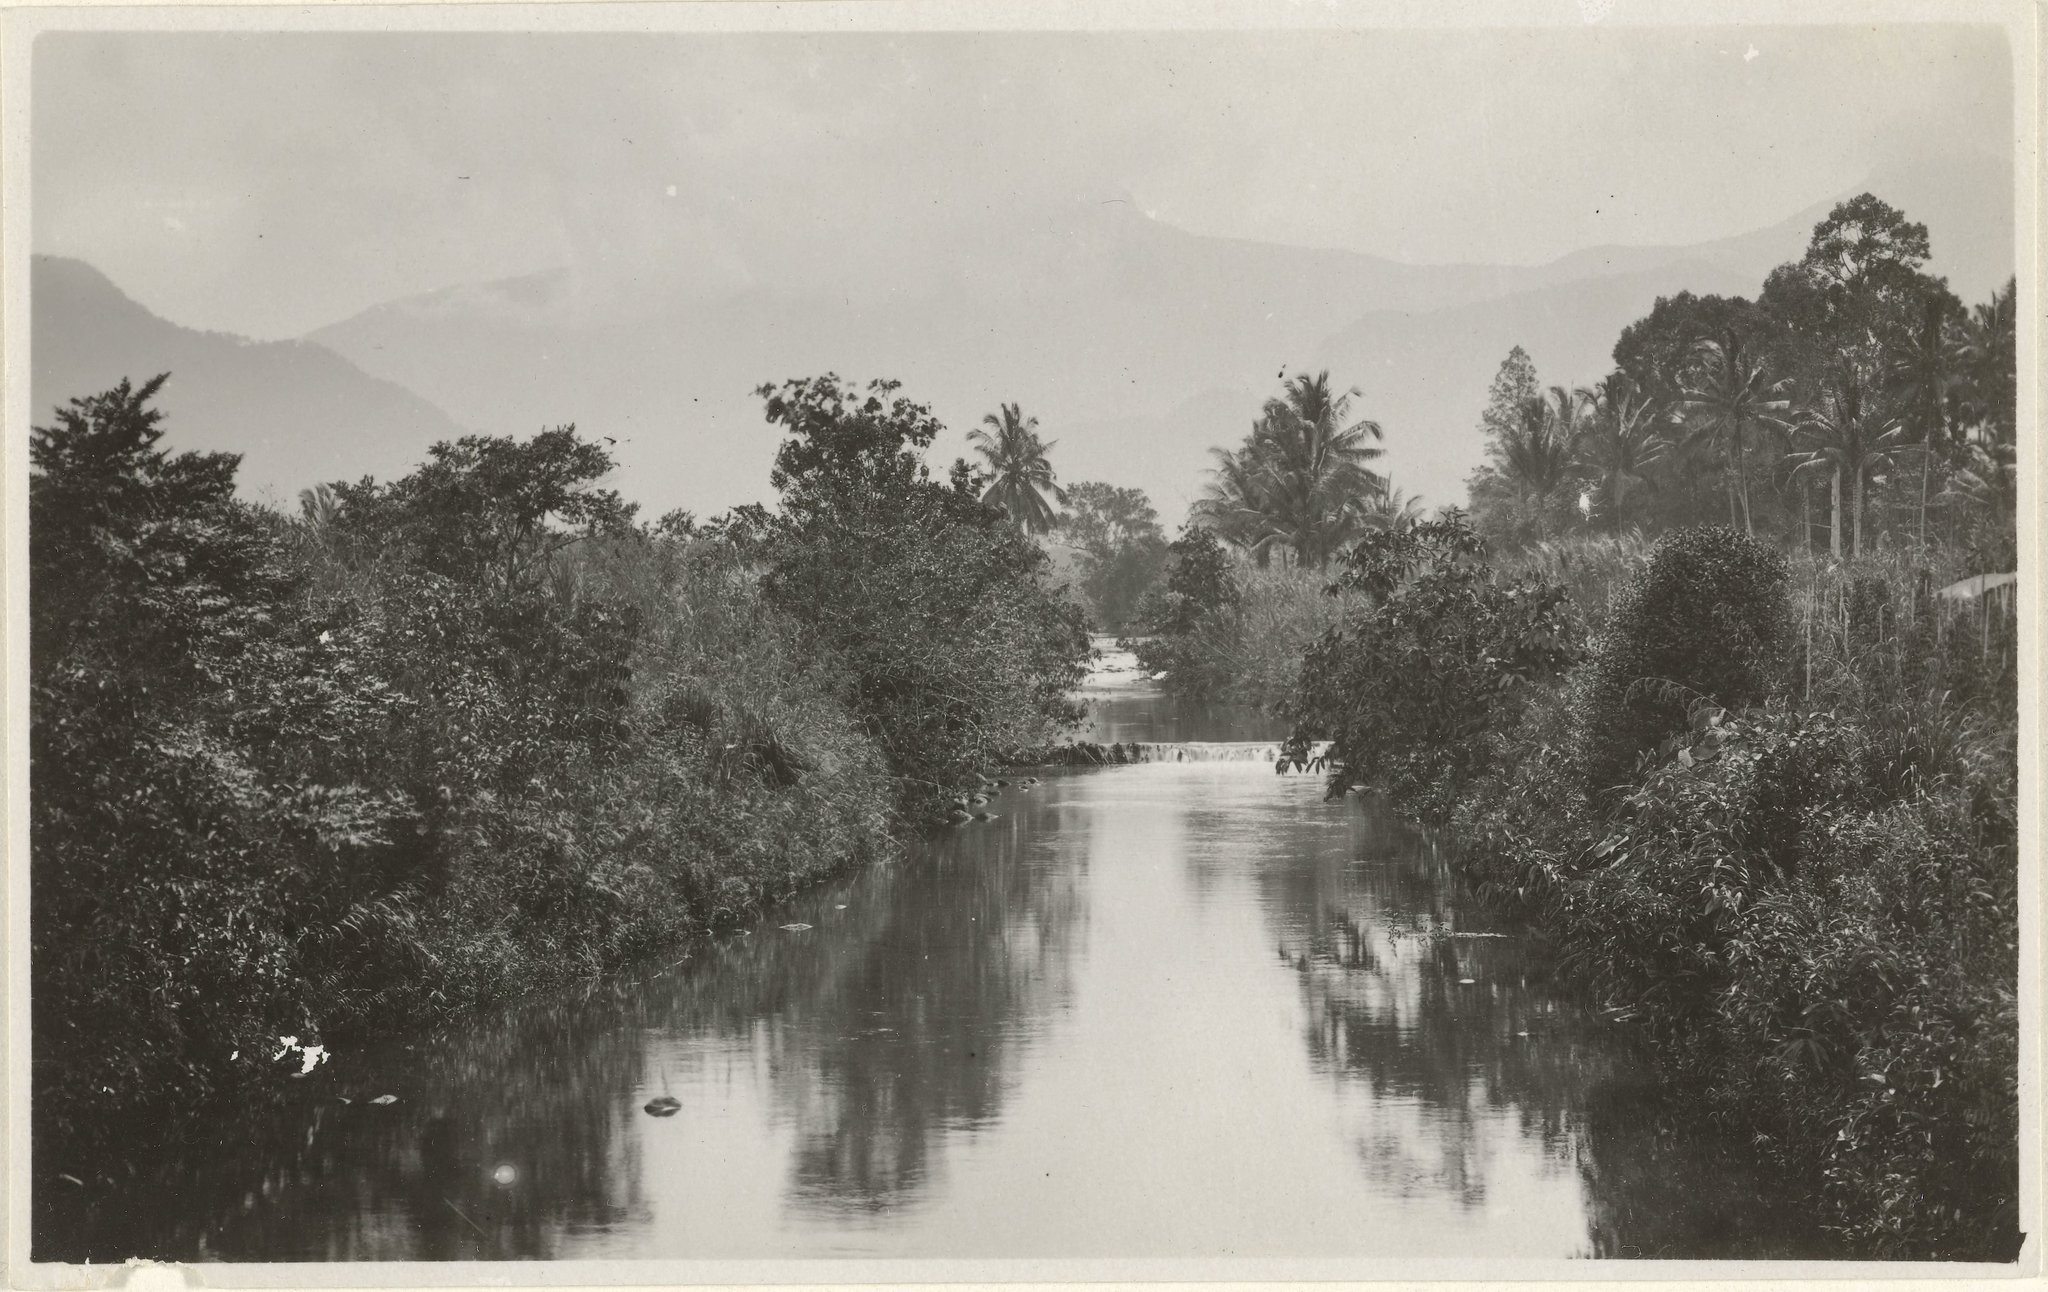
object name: photograph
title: Riviergezicht in de tropen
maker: Anonymous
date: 1920-1940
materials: photographic support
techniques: gelatin silver print